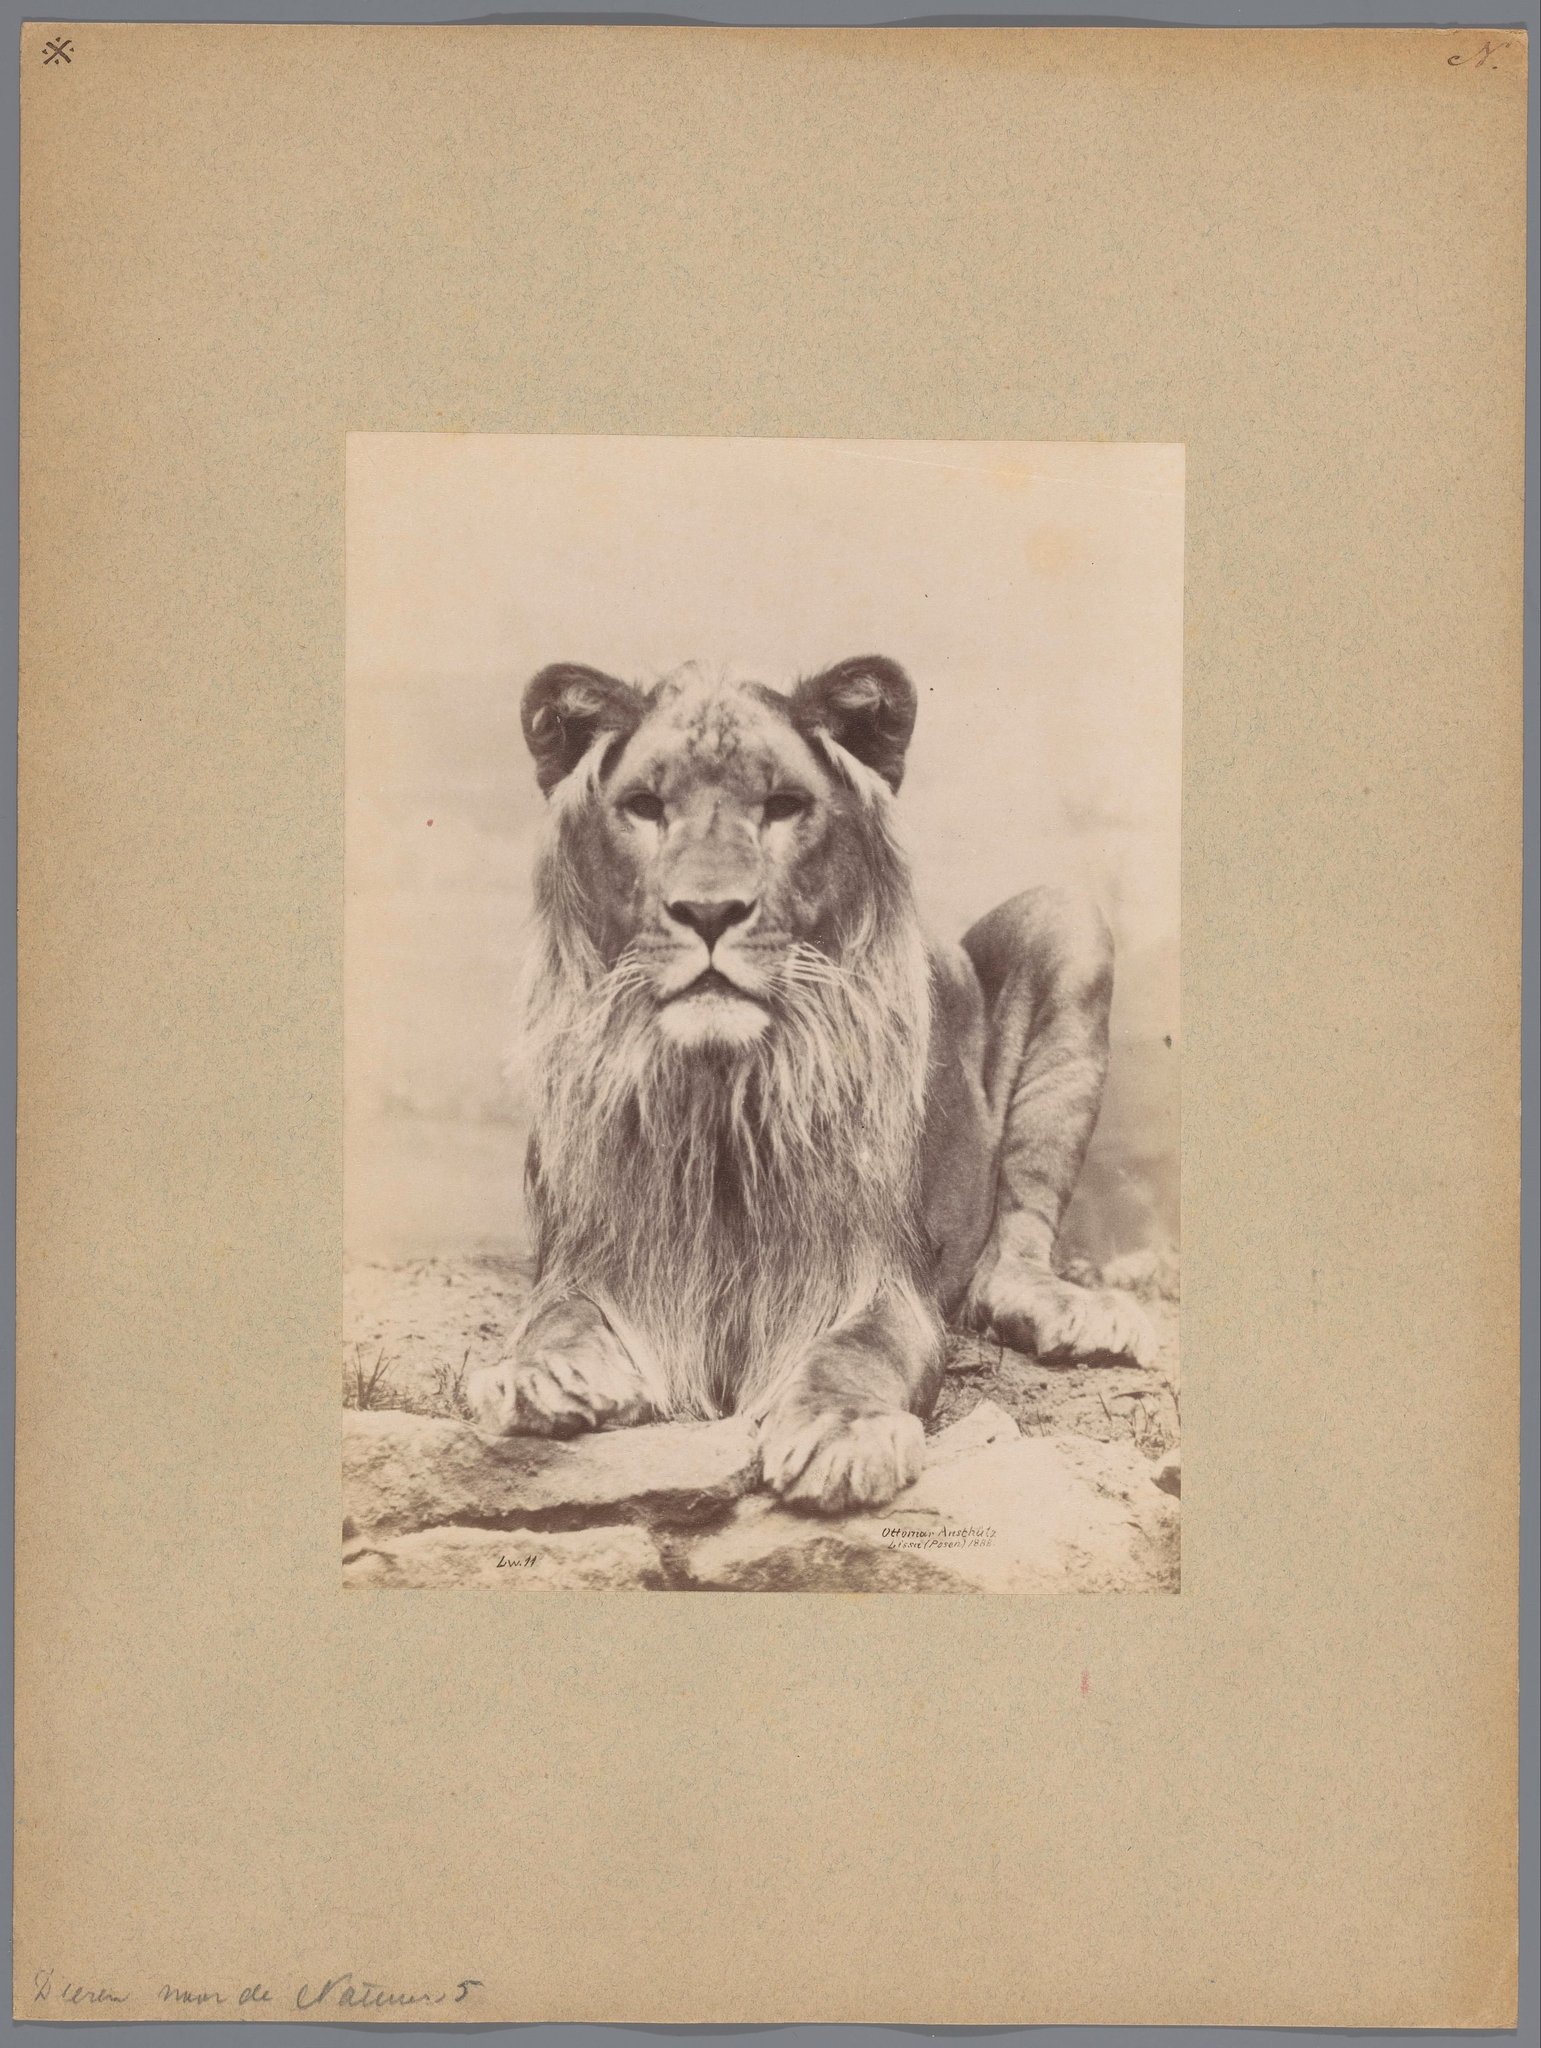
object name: photograph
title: Leeuw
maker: ottomar anschütz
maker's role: fotograaf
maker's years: 1846-1907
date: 1888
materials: cardboard, photographic support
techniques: albumen print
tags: beasts of prey, predatory animals: lion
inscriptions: annotation: ‘N.’, collector's mark: ‘RIJKS-NORMAALSCHOOL-VOOR-TEEKENONDERWIJZERS-AMSTERDAM’, number: ‘Lw.11’, name: ‘Ottomar Anschütz Lissa (Posen) 1888.’